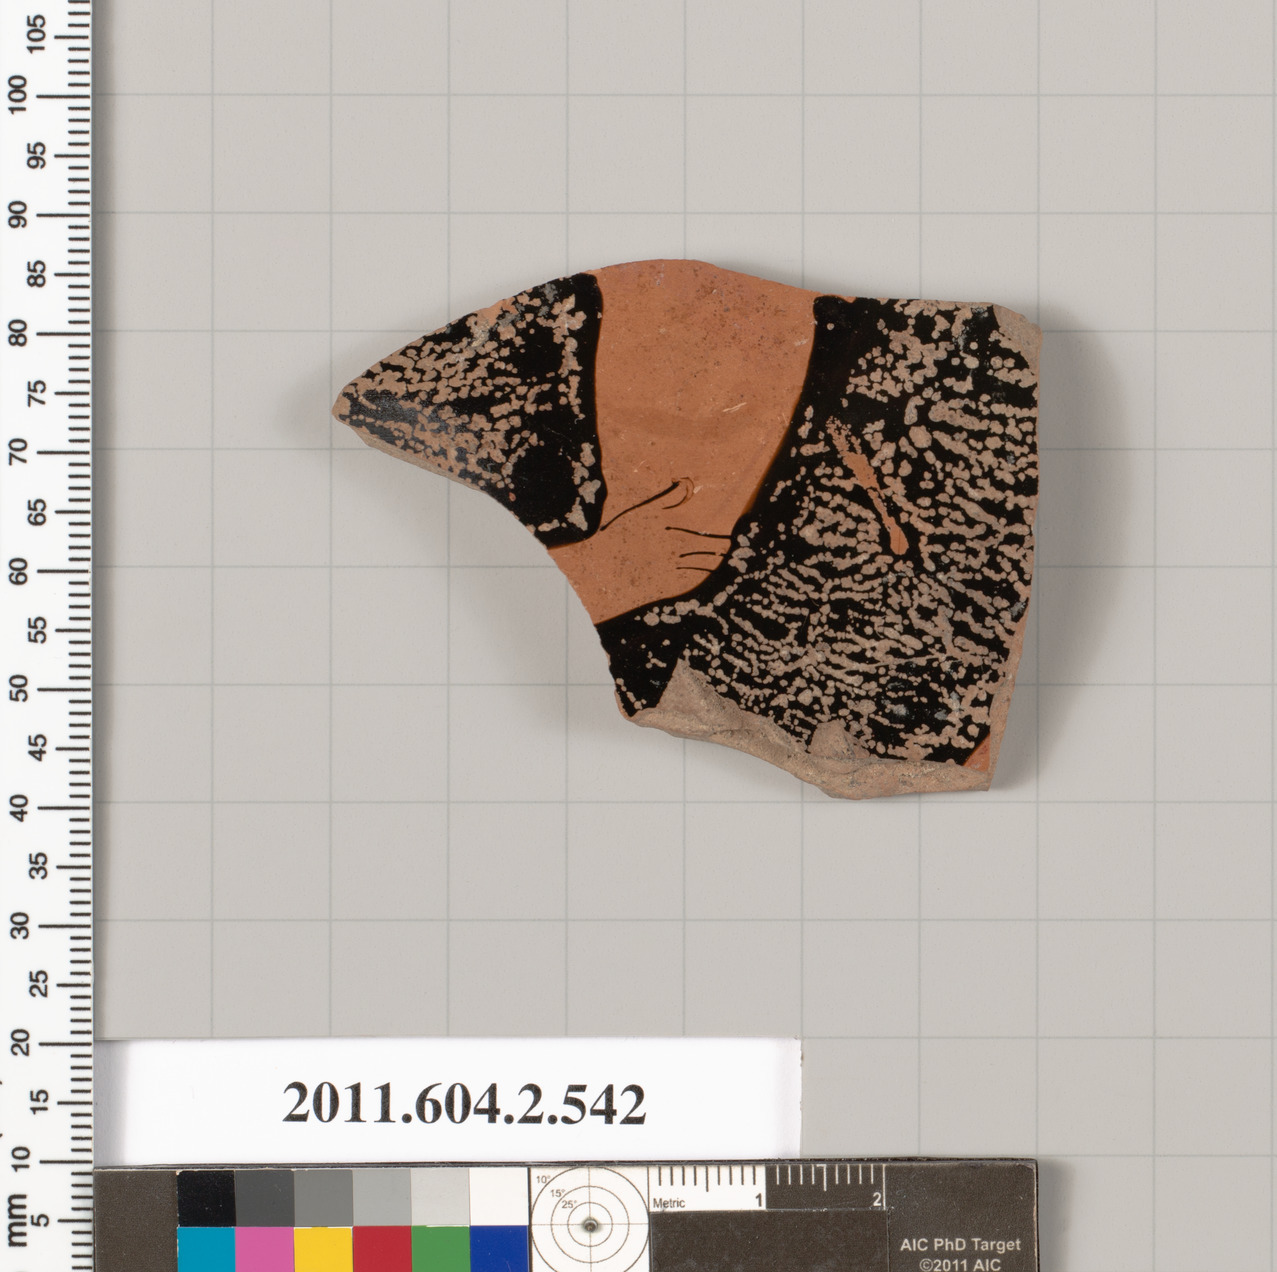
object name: column krater fragment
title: Terracotta fragment of a column-krater (bowl for mixing wine and water)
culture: greek, attic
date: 440-420 BCE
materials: terracotta